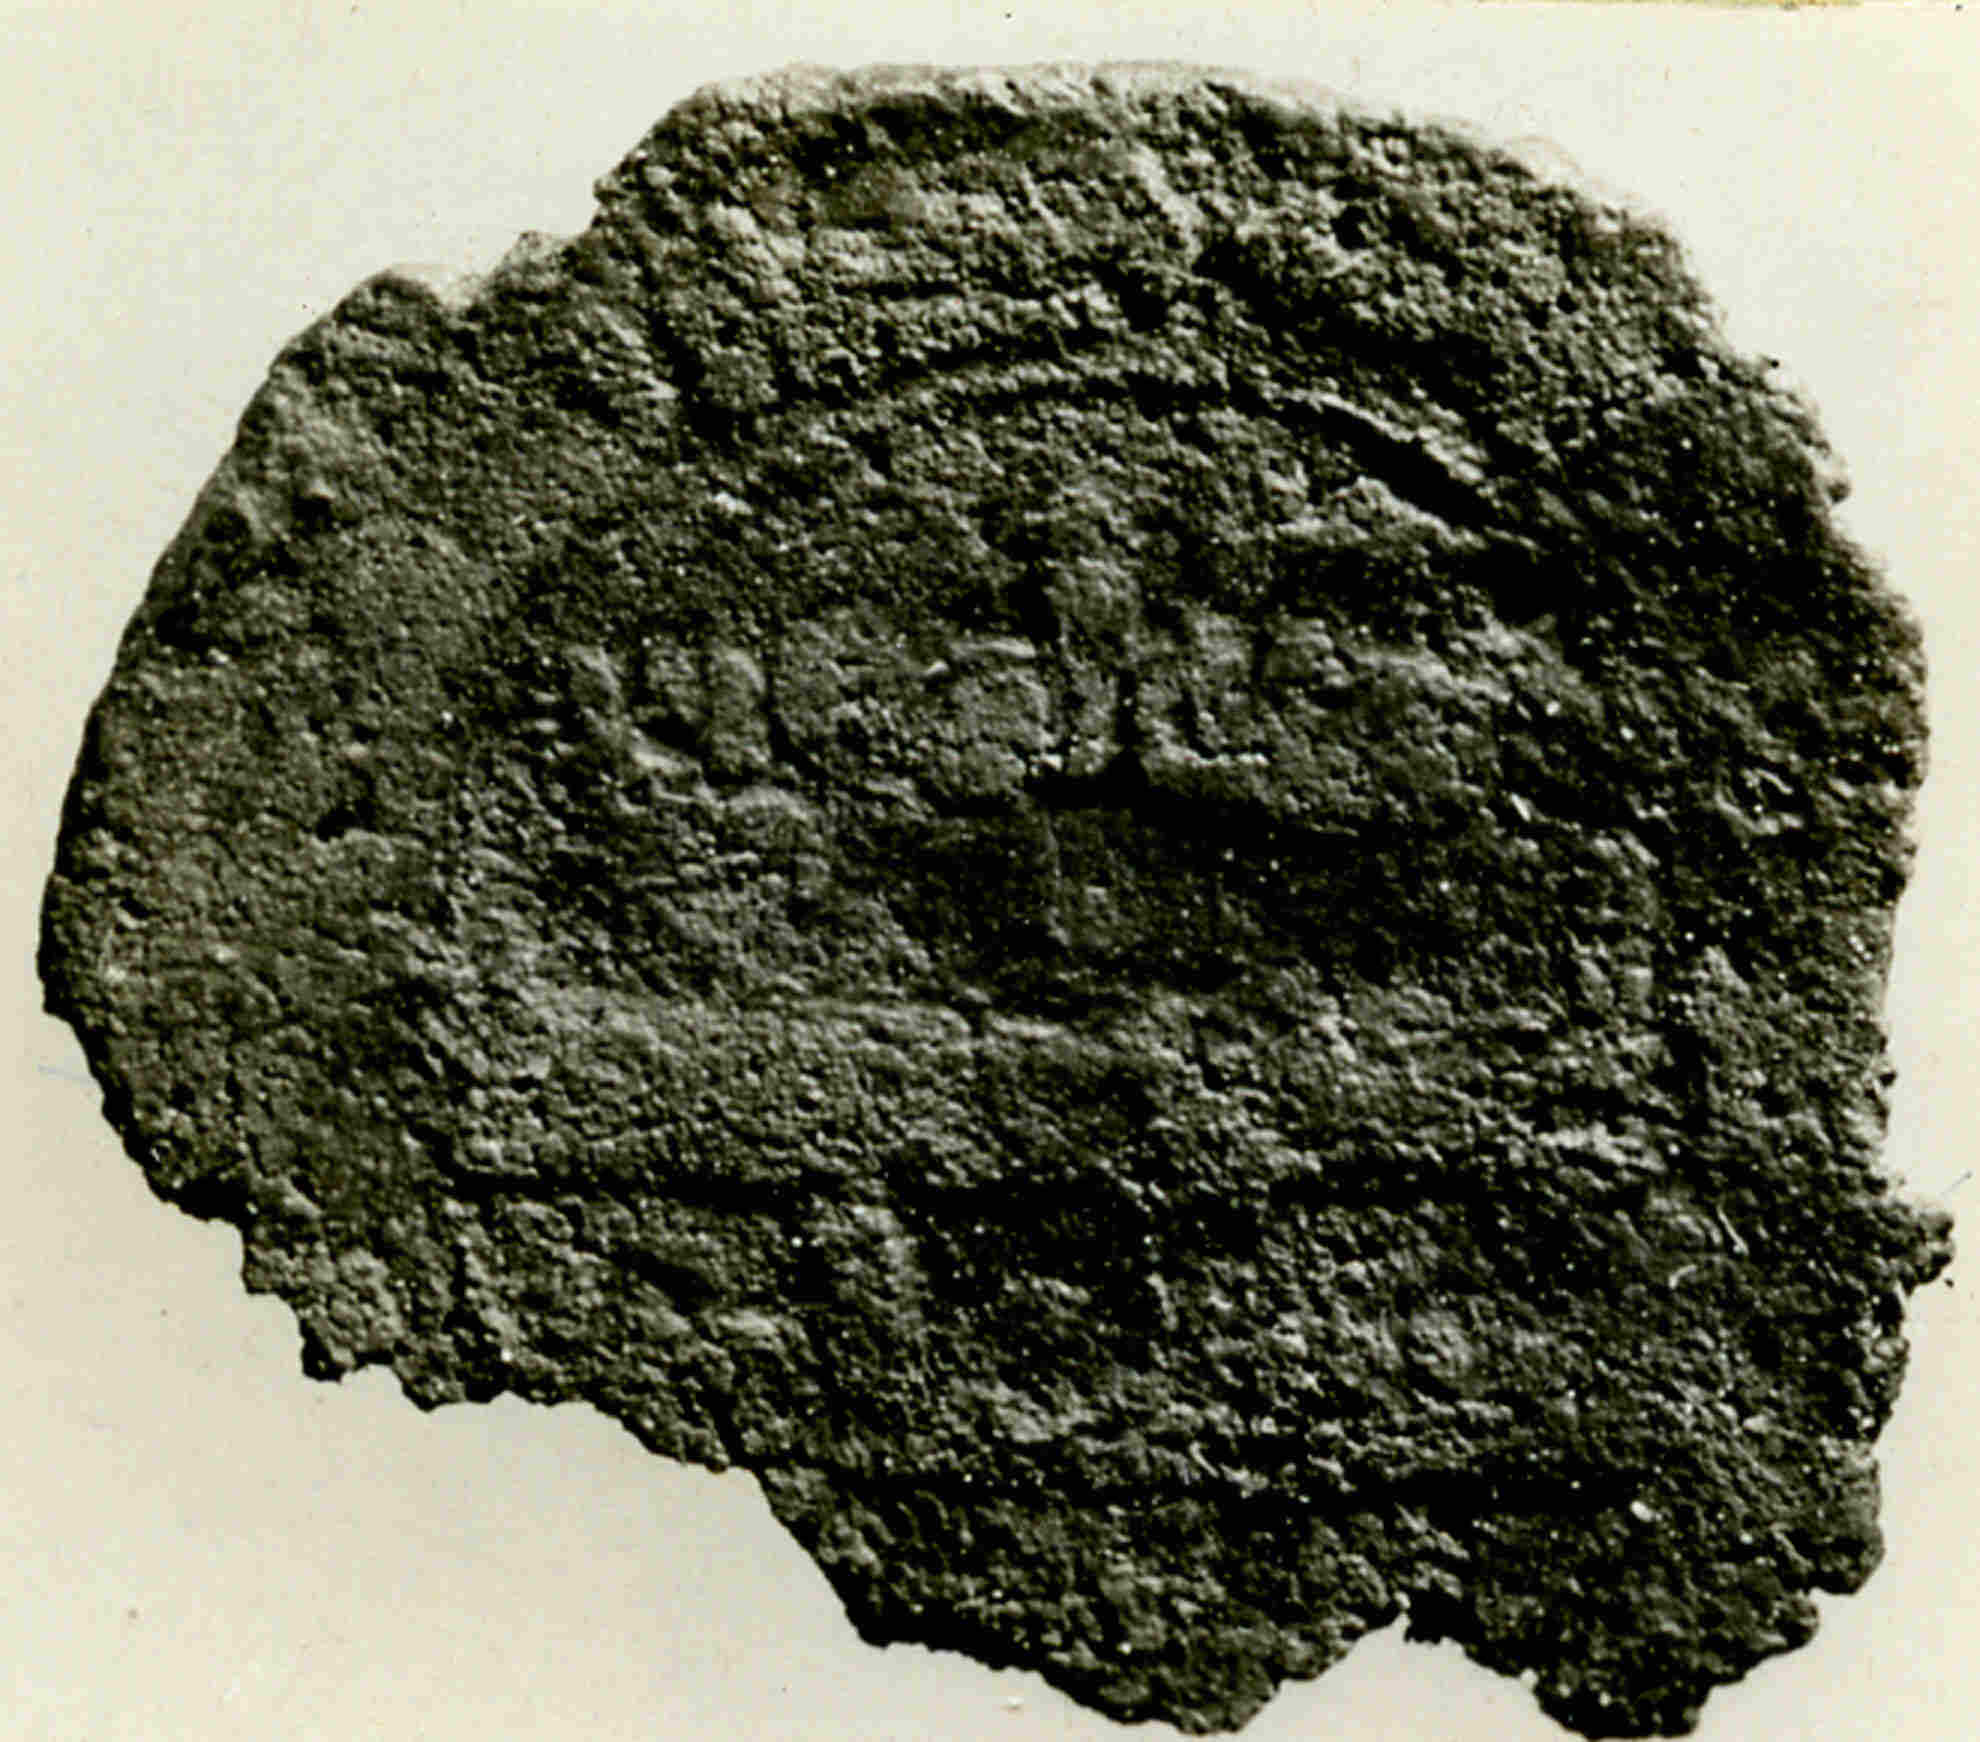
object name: coin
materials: copper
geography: iran